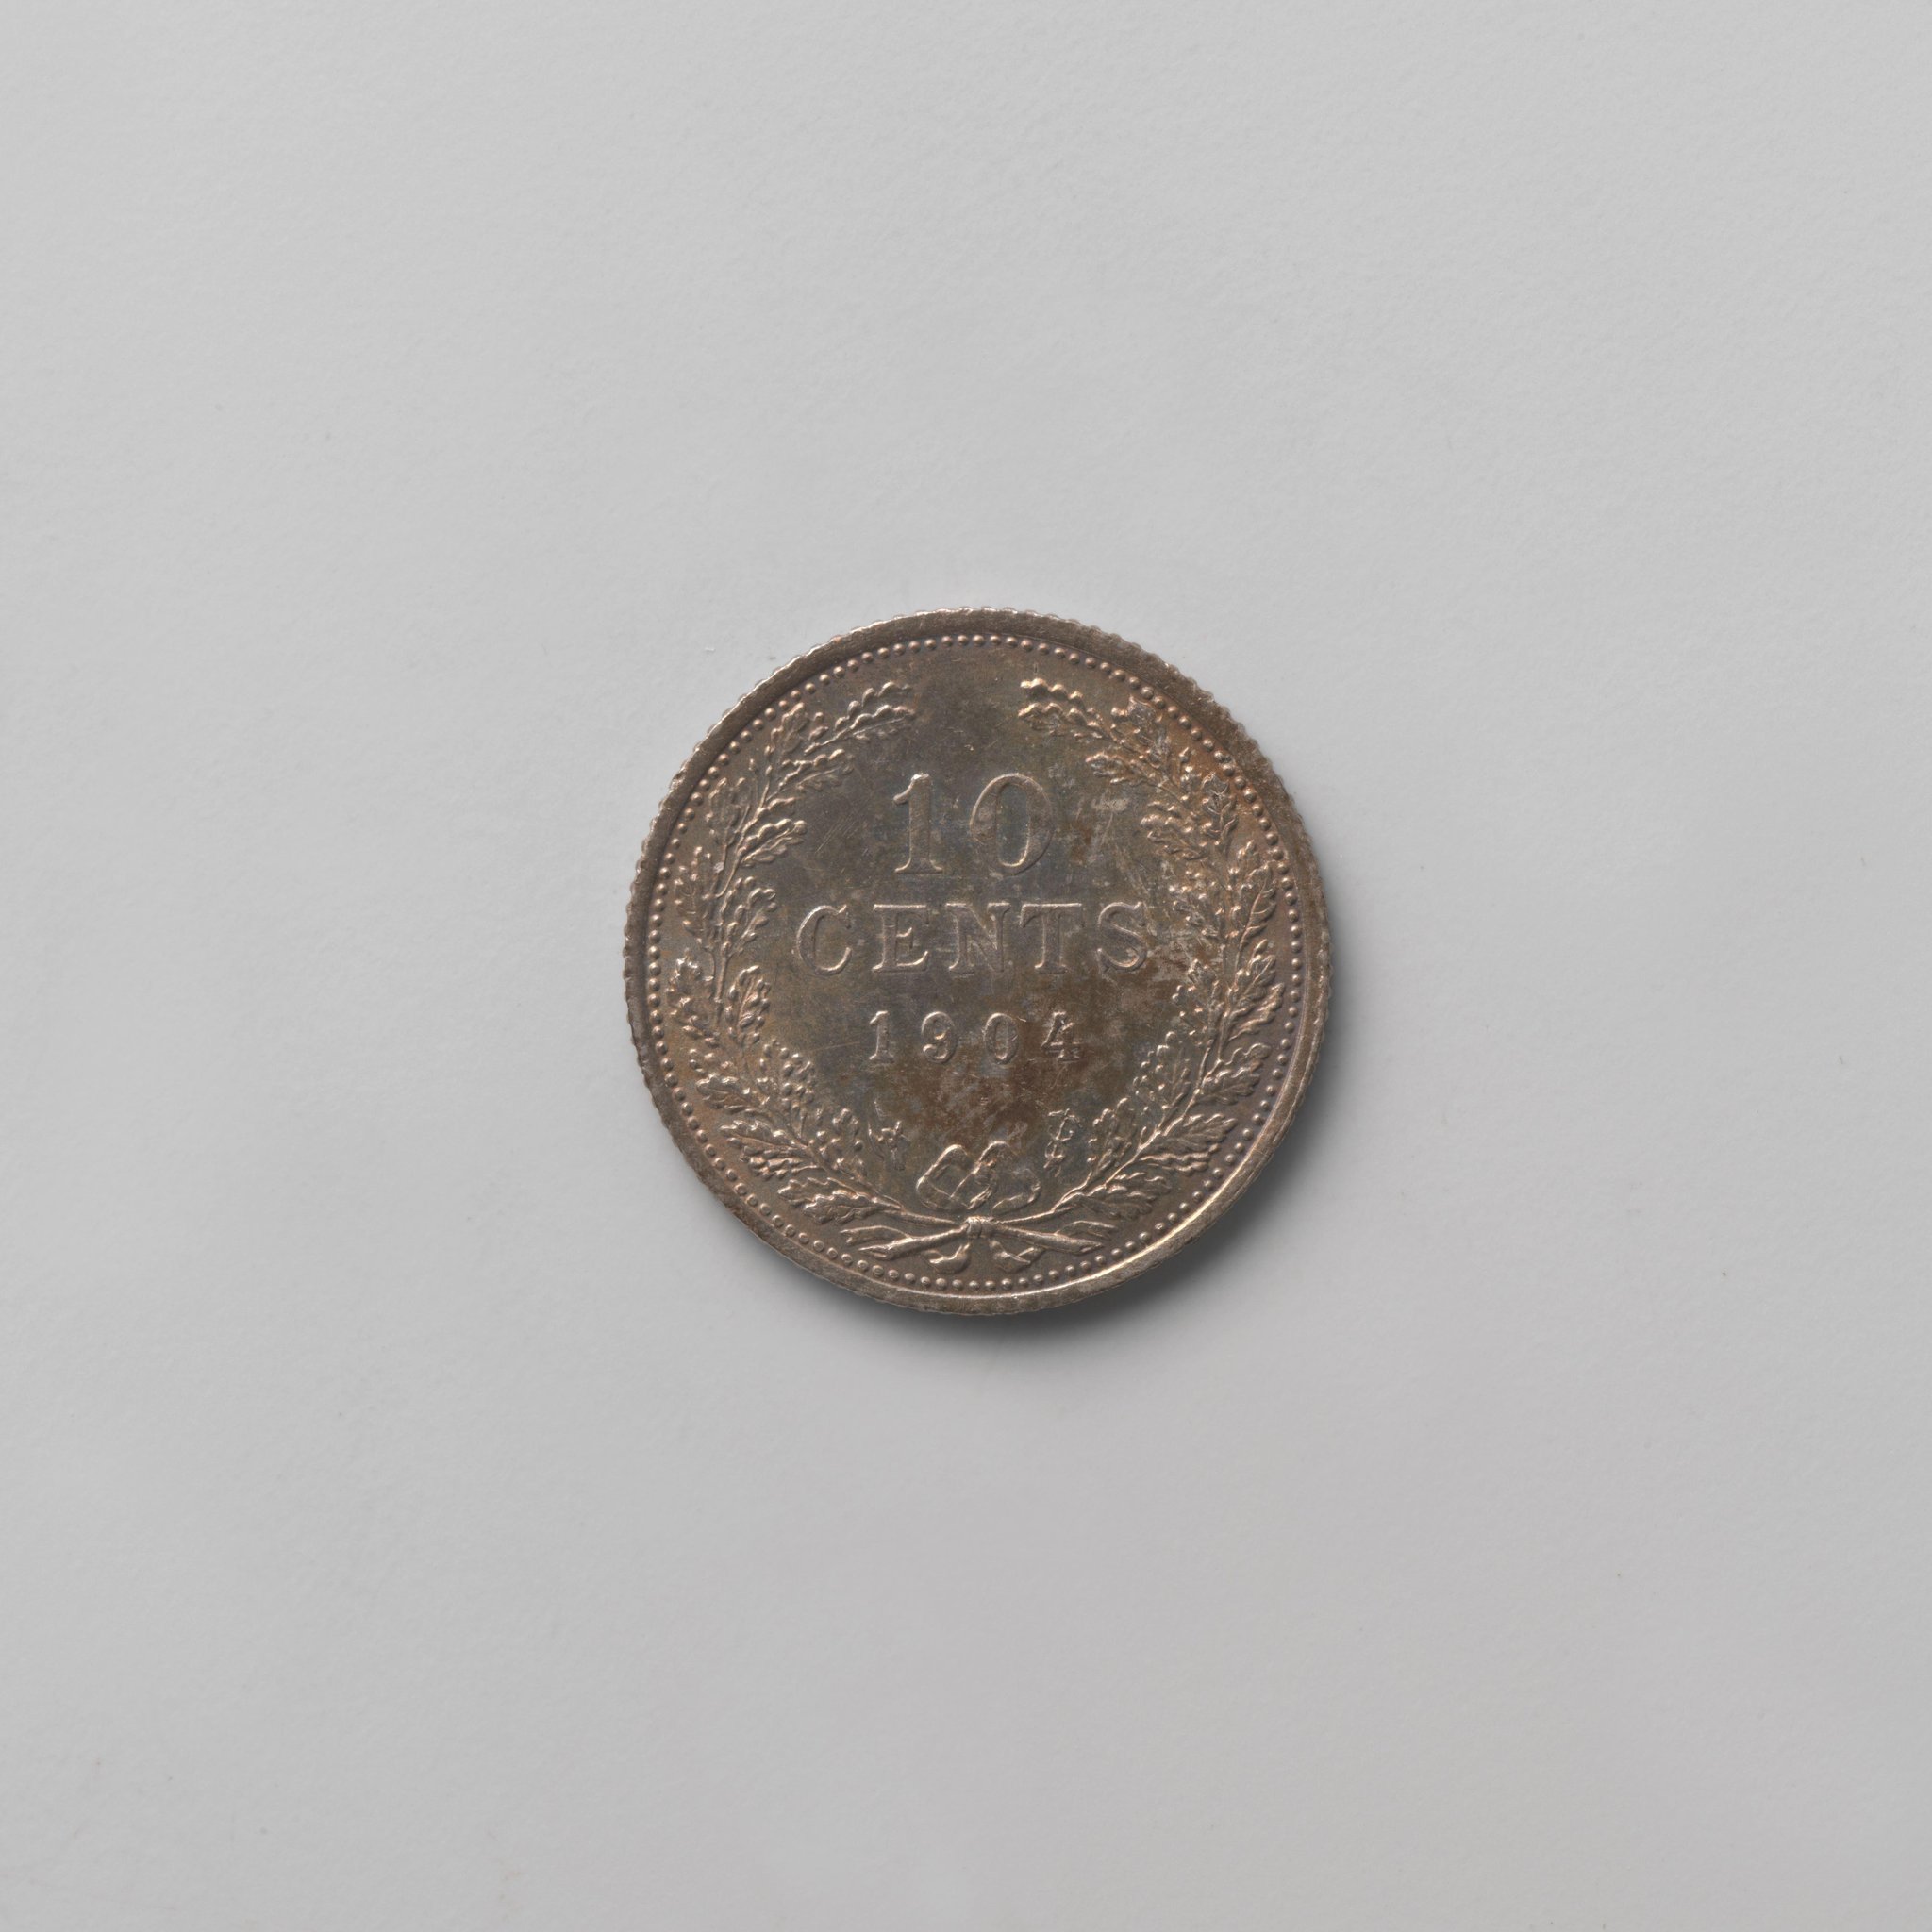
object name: coin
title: Nederland,10 cent,1904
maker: wilhelmina of the netherlands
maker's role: print maker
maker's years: 1880-1962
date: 1904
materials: silver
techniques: striking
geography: utrecht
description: Zilveren munt. Voorzijde: hoofd met diadeem naar links. Keerzijde: binnen twee samengebonden eiketakken waarde-aanduiding 10 cents en jaartal. Kartelrand.